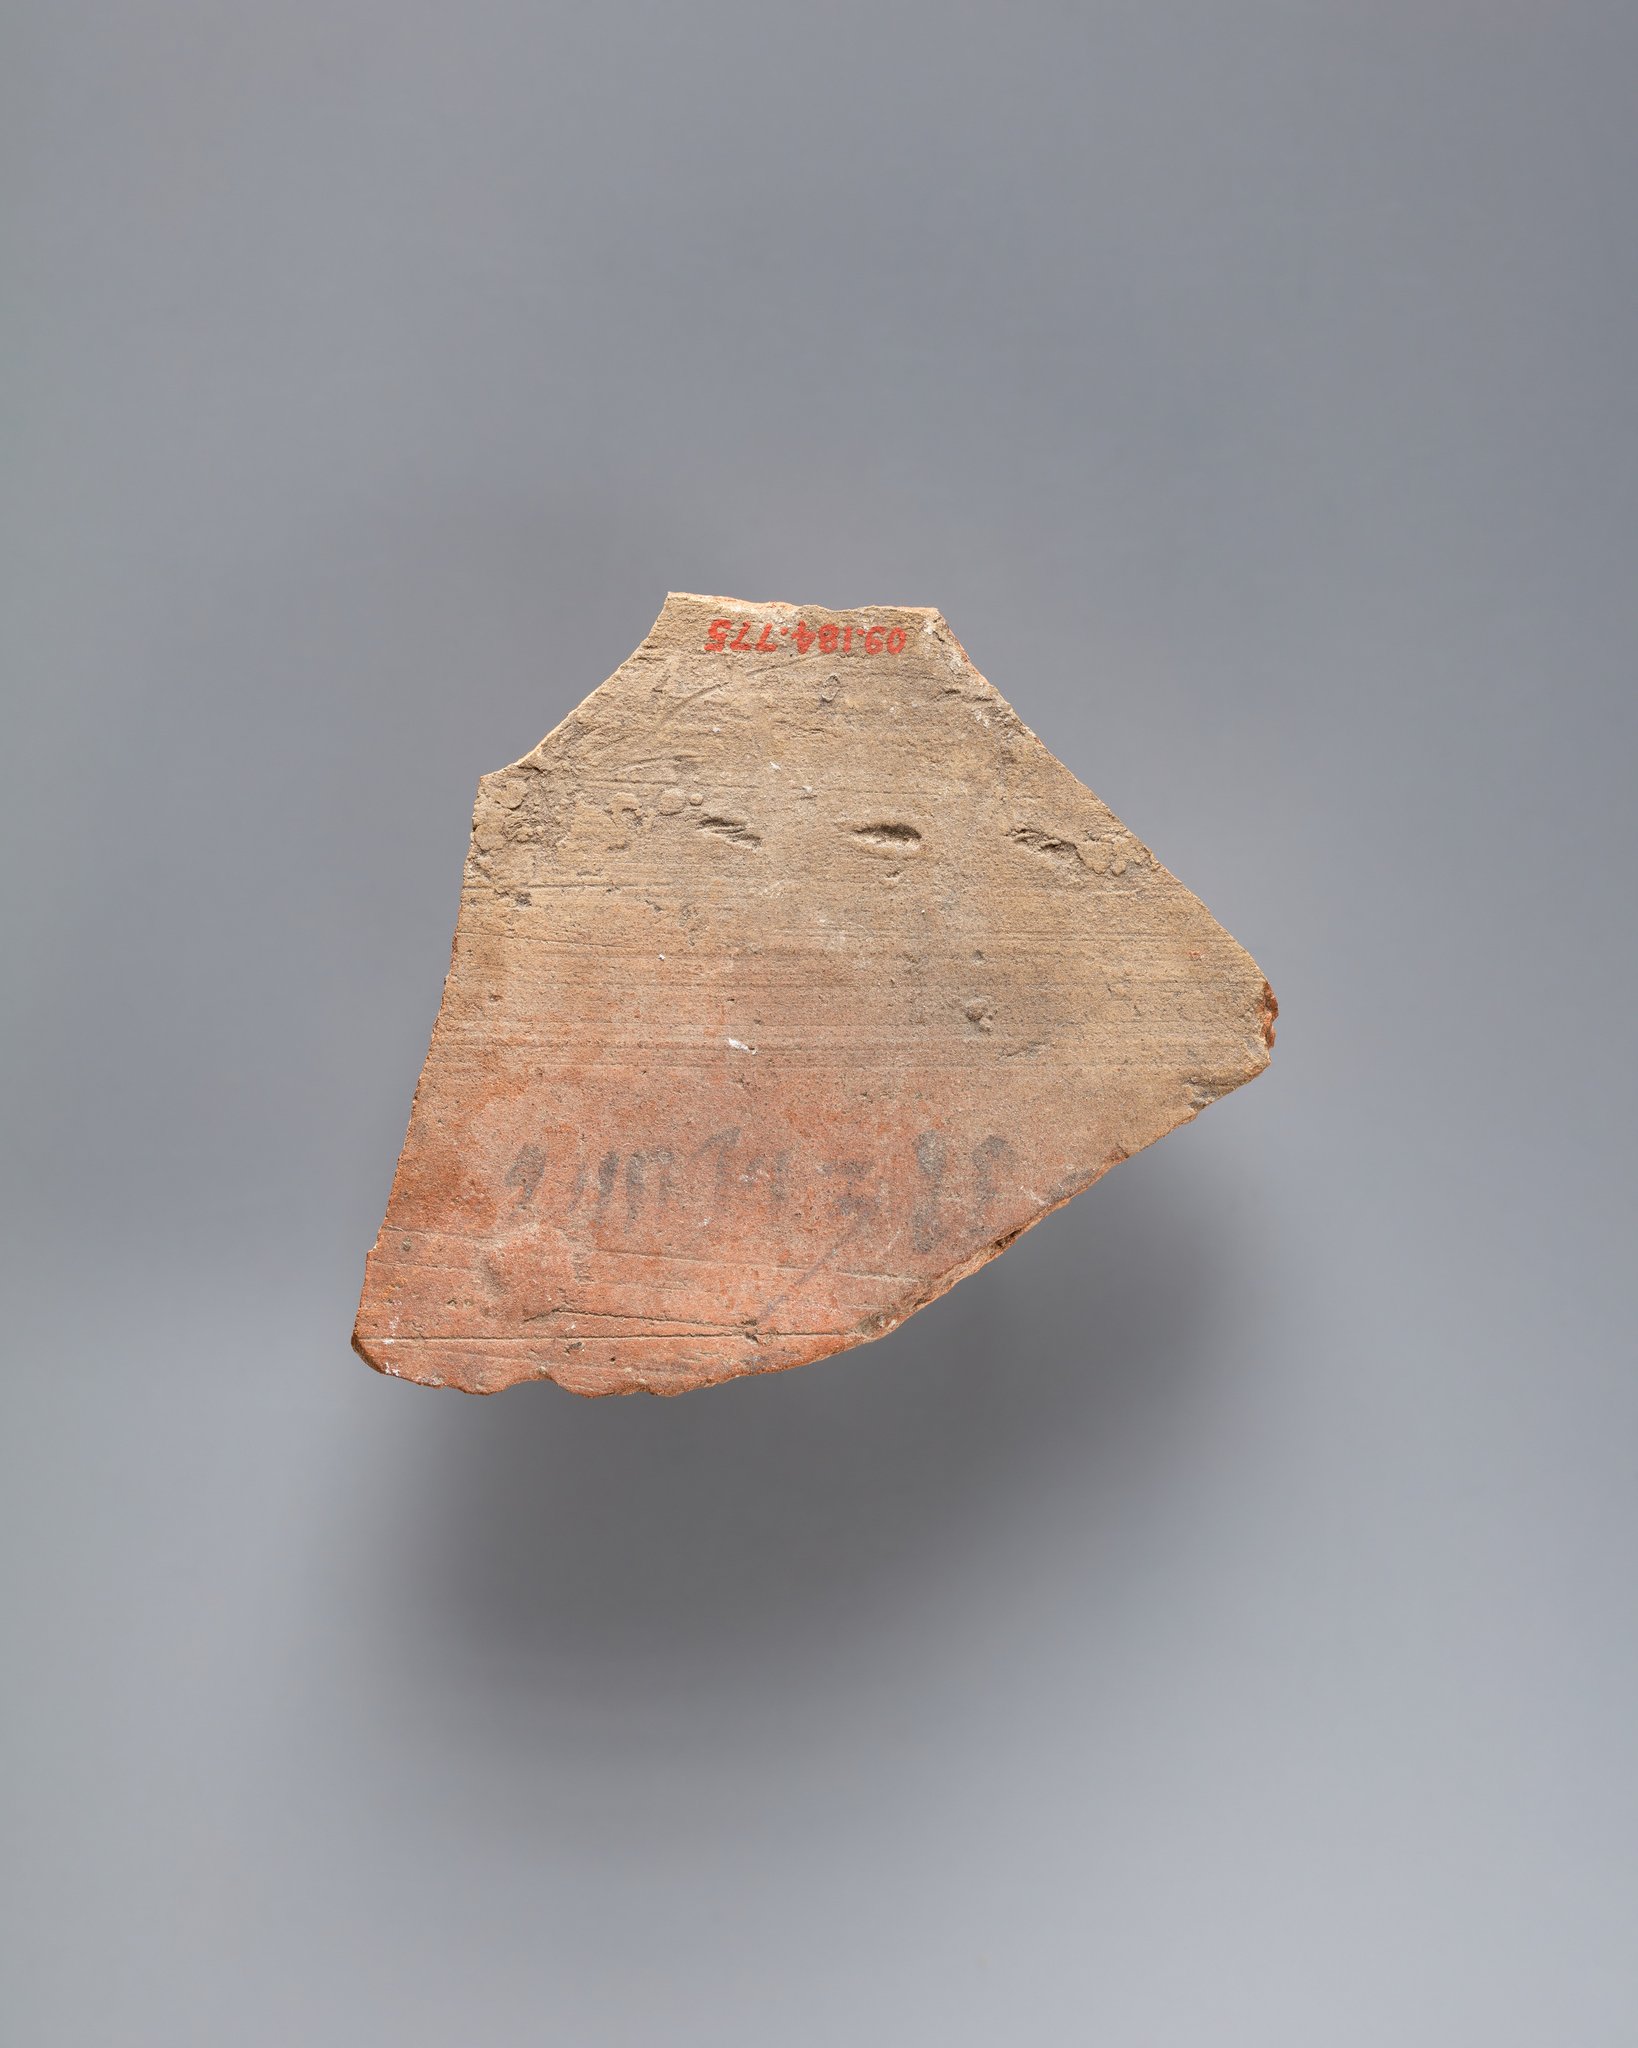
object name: ostracon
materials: ink, pottery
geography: egypt